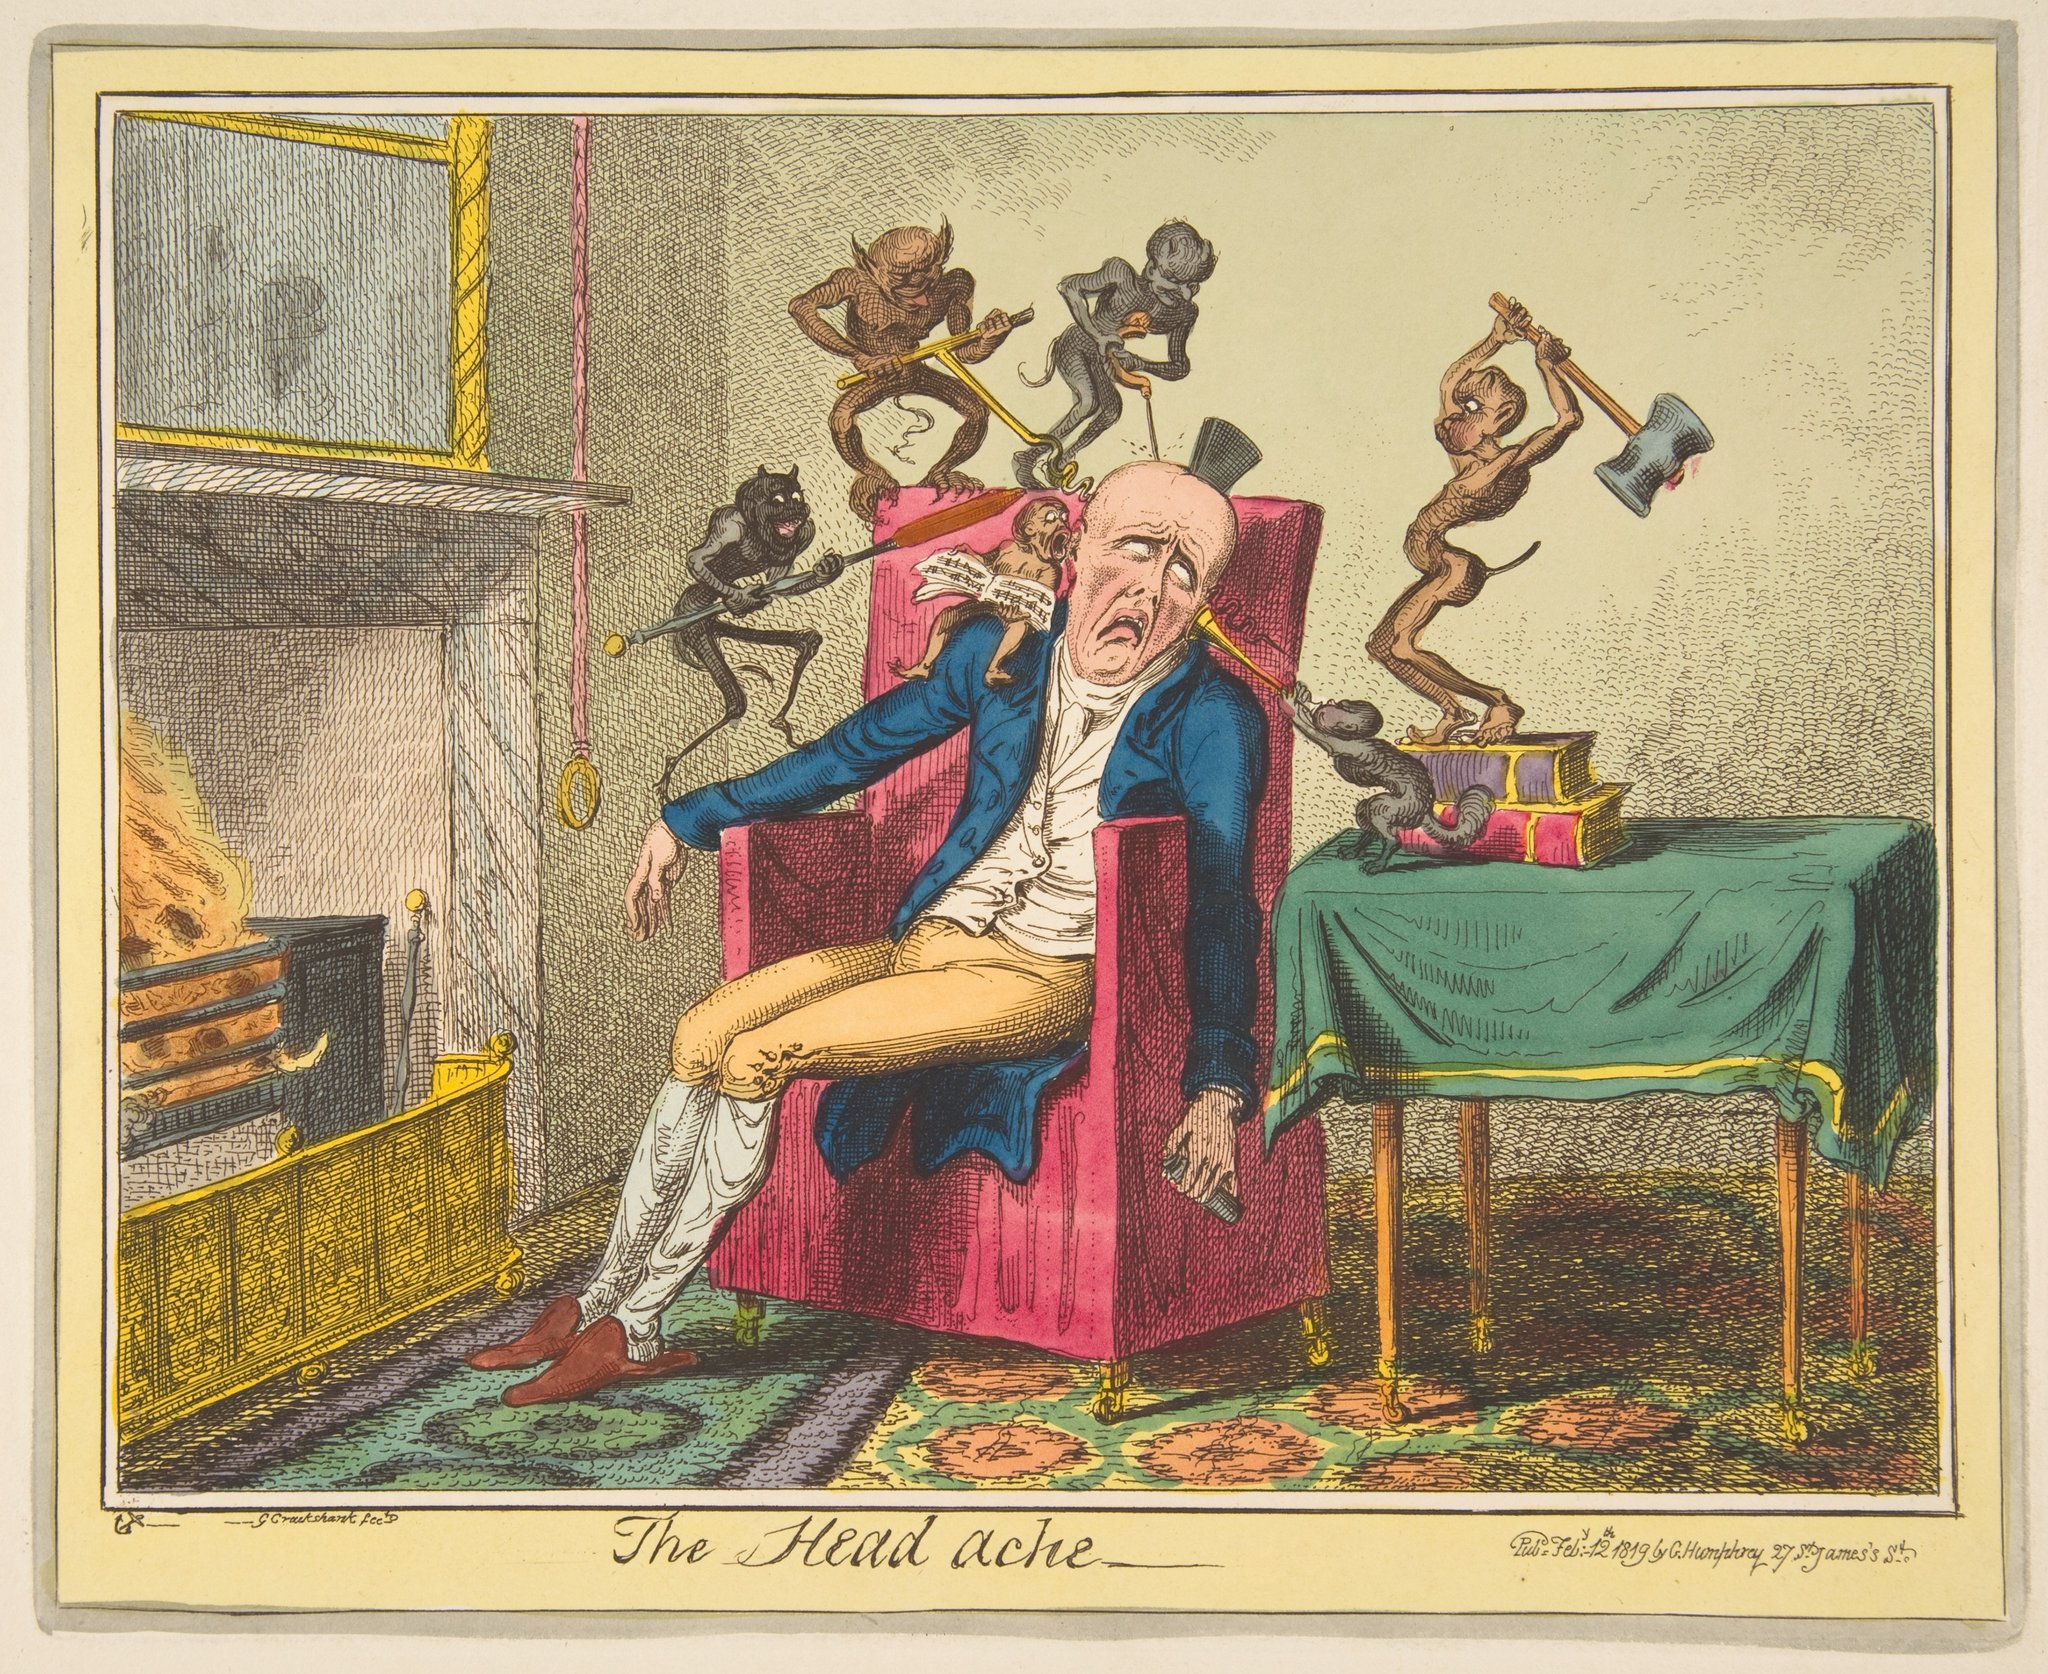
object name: print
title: The Head Ache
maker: george cruikshank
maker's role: artist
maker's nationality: british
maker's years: 1792-1878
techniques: etching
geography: london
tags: satire,men,demons,hammers